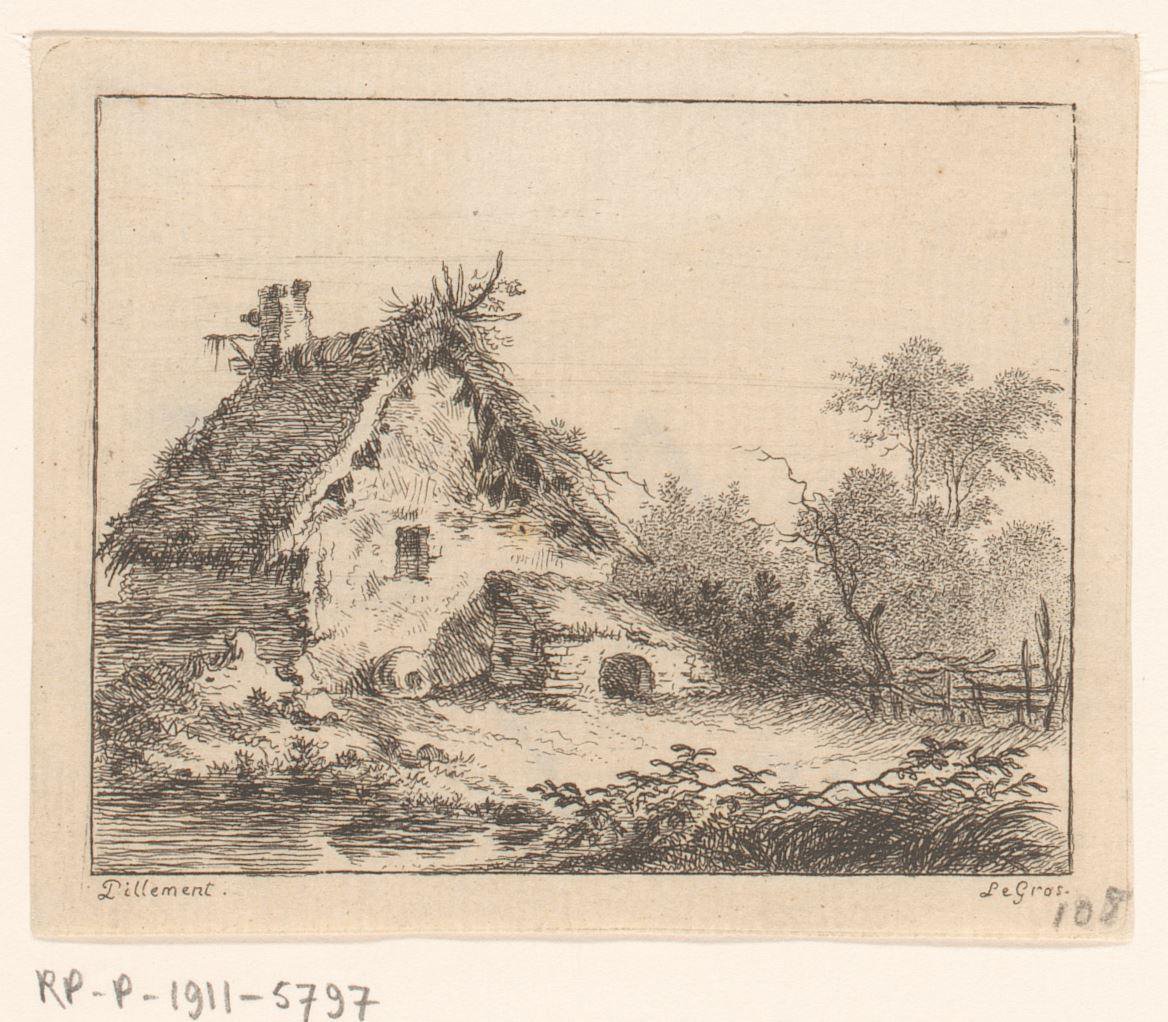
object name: print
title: Landelijke woning in een landschap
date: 1764-1834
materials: paper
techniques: etching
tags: rural housing, e.g. country-house, villa, cottage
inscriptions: collector's mark: Lugt 2228